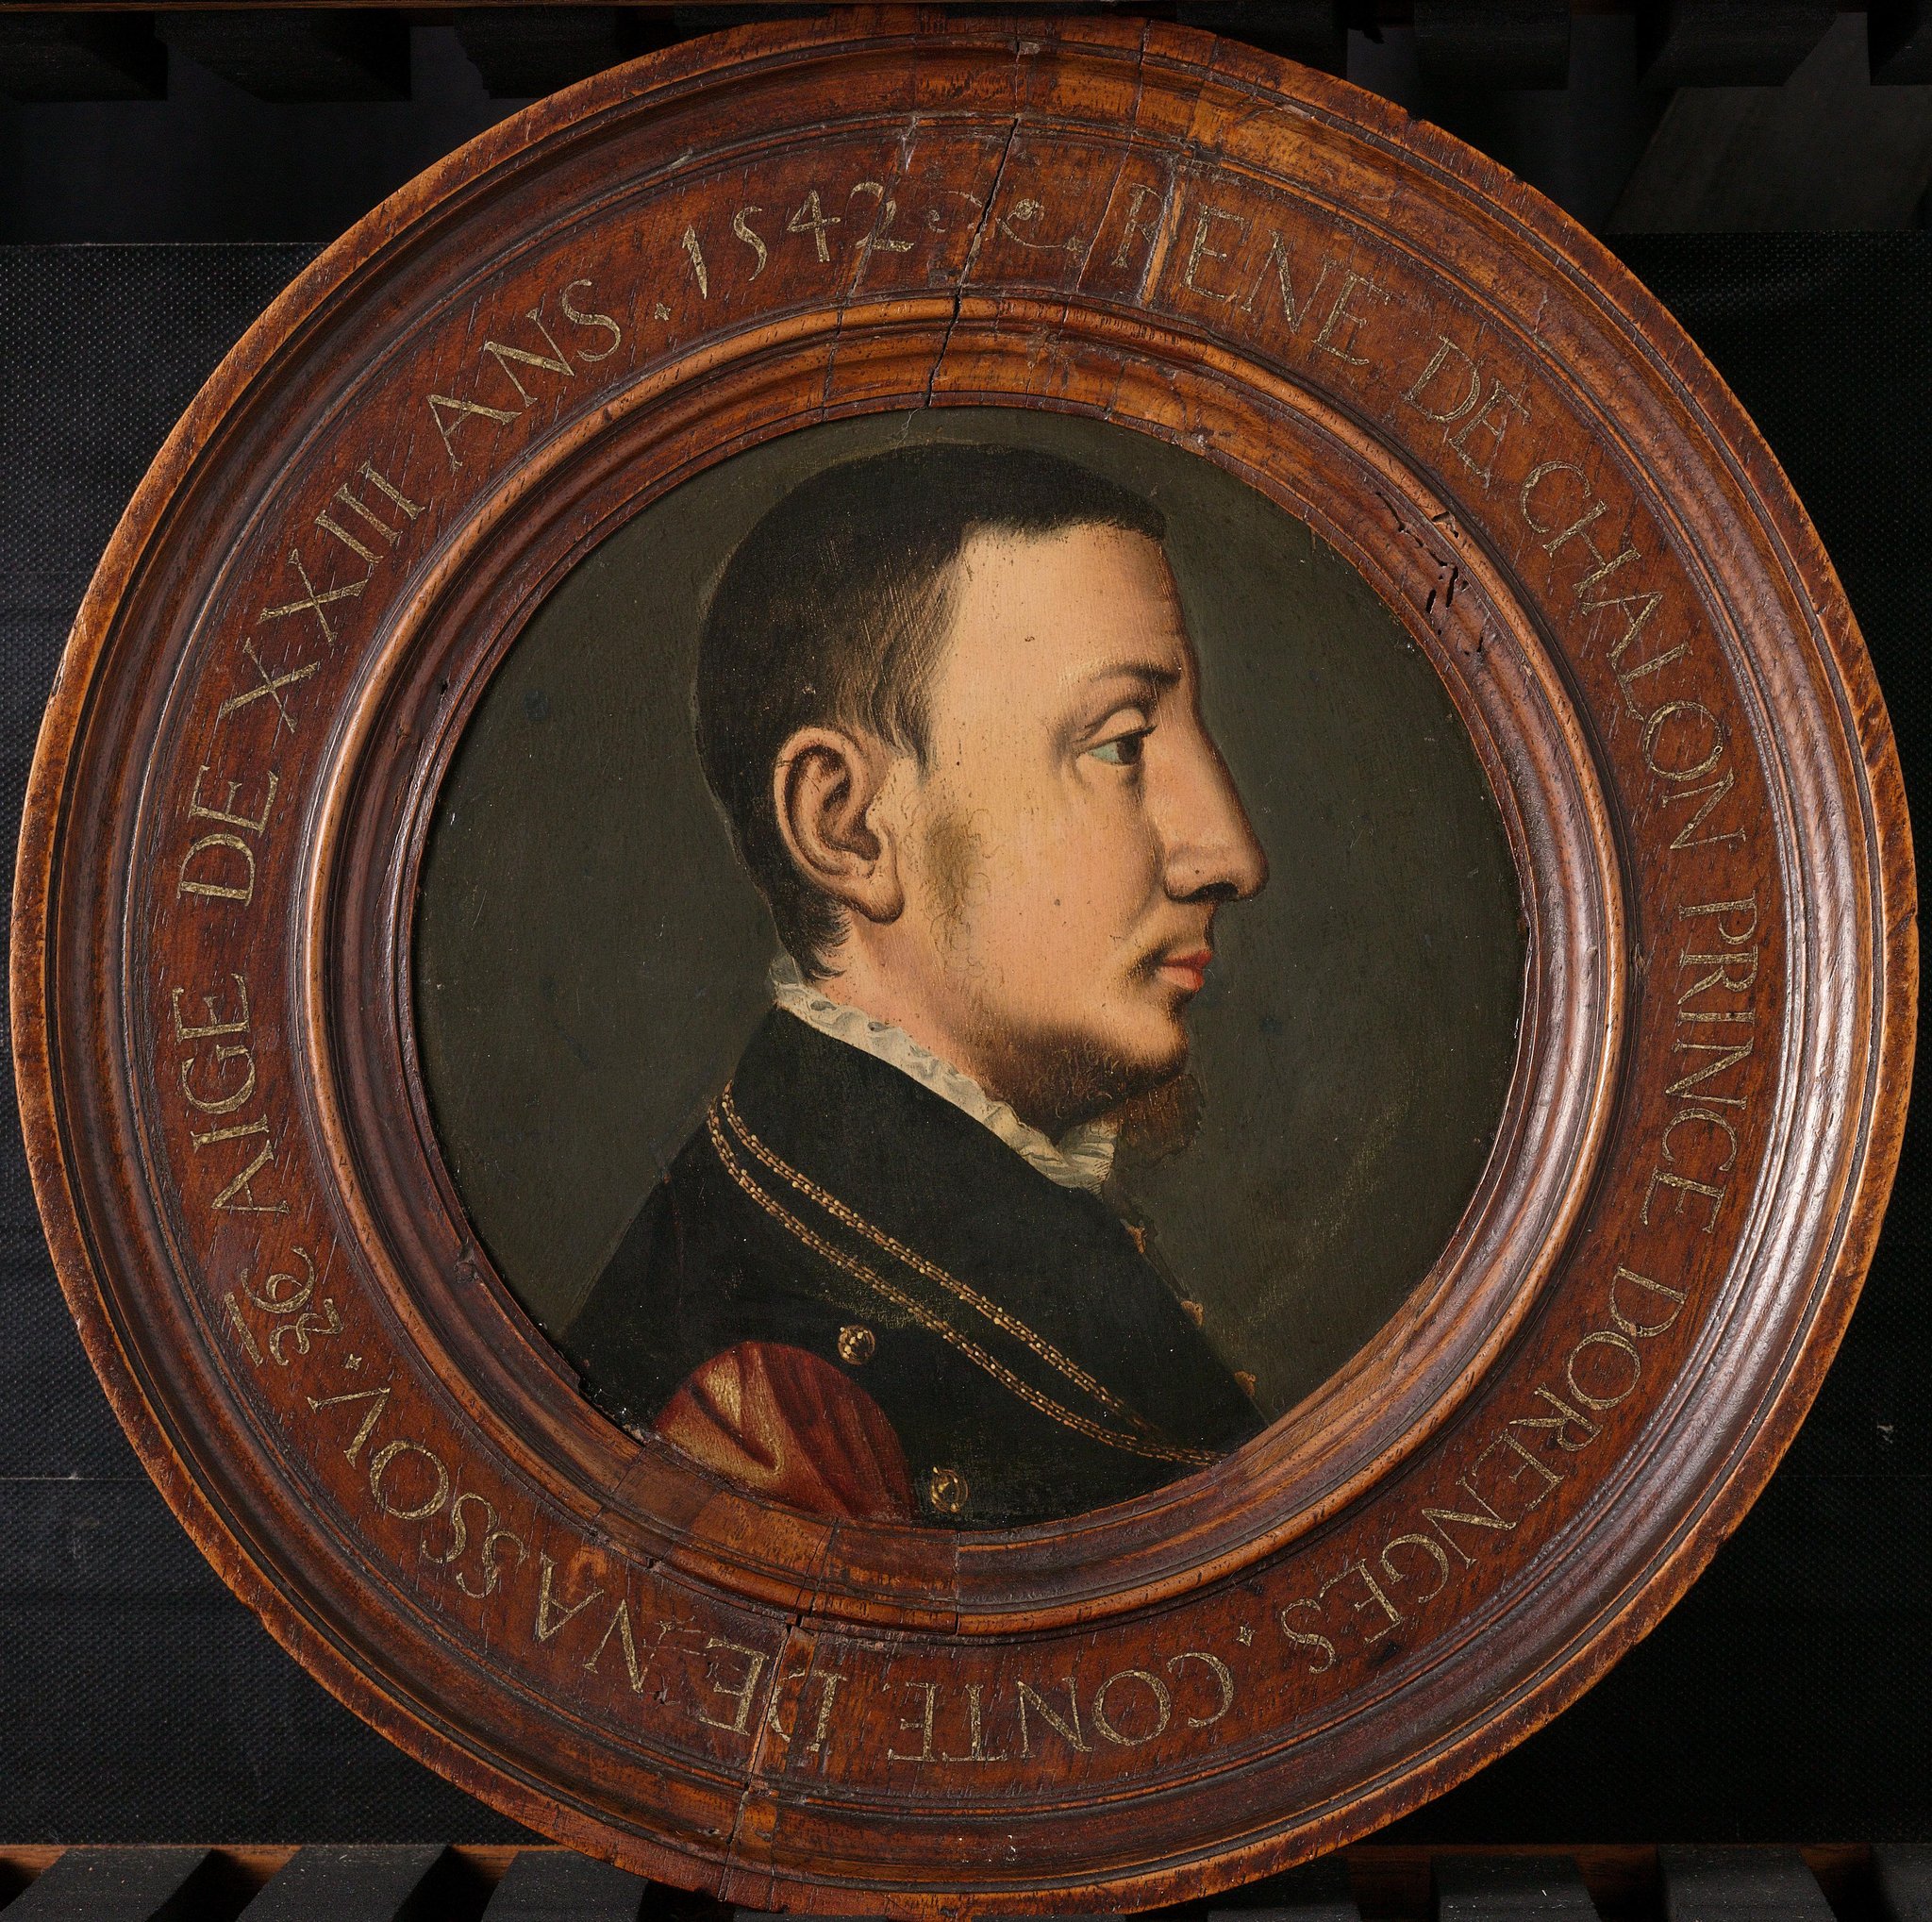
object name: painting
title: Portrait of René de Chalon (c. 1519-1544), Prince of Orange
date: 1542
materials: oil, panel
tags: historical persons (+ profile portrait)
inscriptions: inscription, on the frame: ‘RENE DE CHALON PRINCE DORENGES. CONTE DE NASSOU. ec. AIGE DE XXIII ANS. 1542.’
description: Portret van René de Chalon (ca. 1518-44), prins van Oranje. Buste en profil naar rechts. Pendant van SK-A-4027.